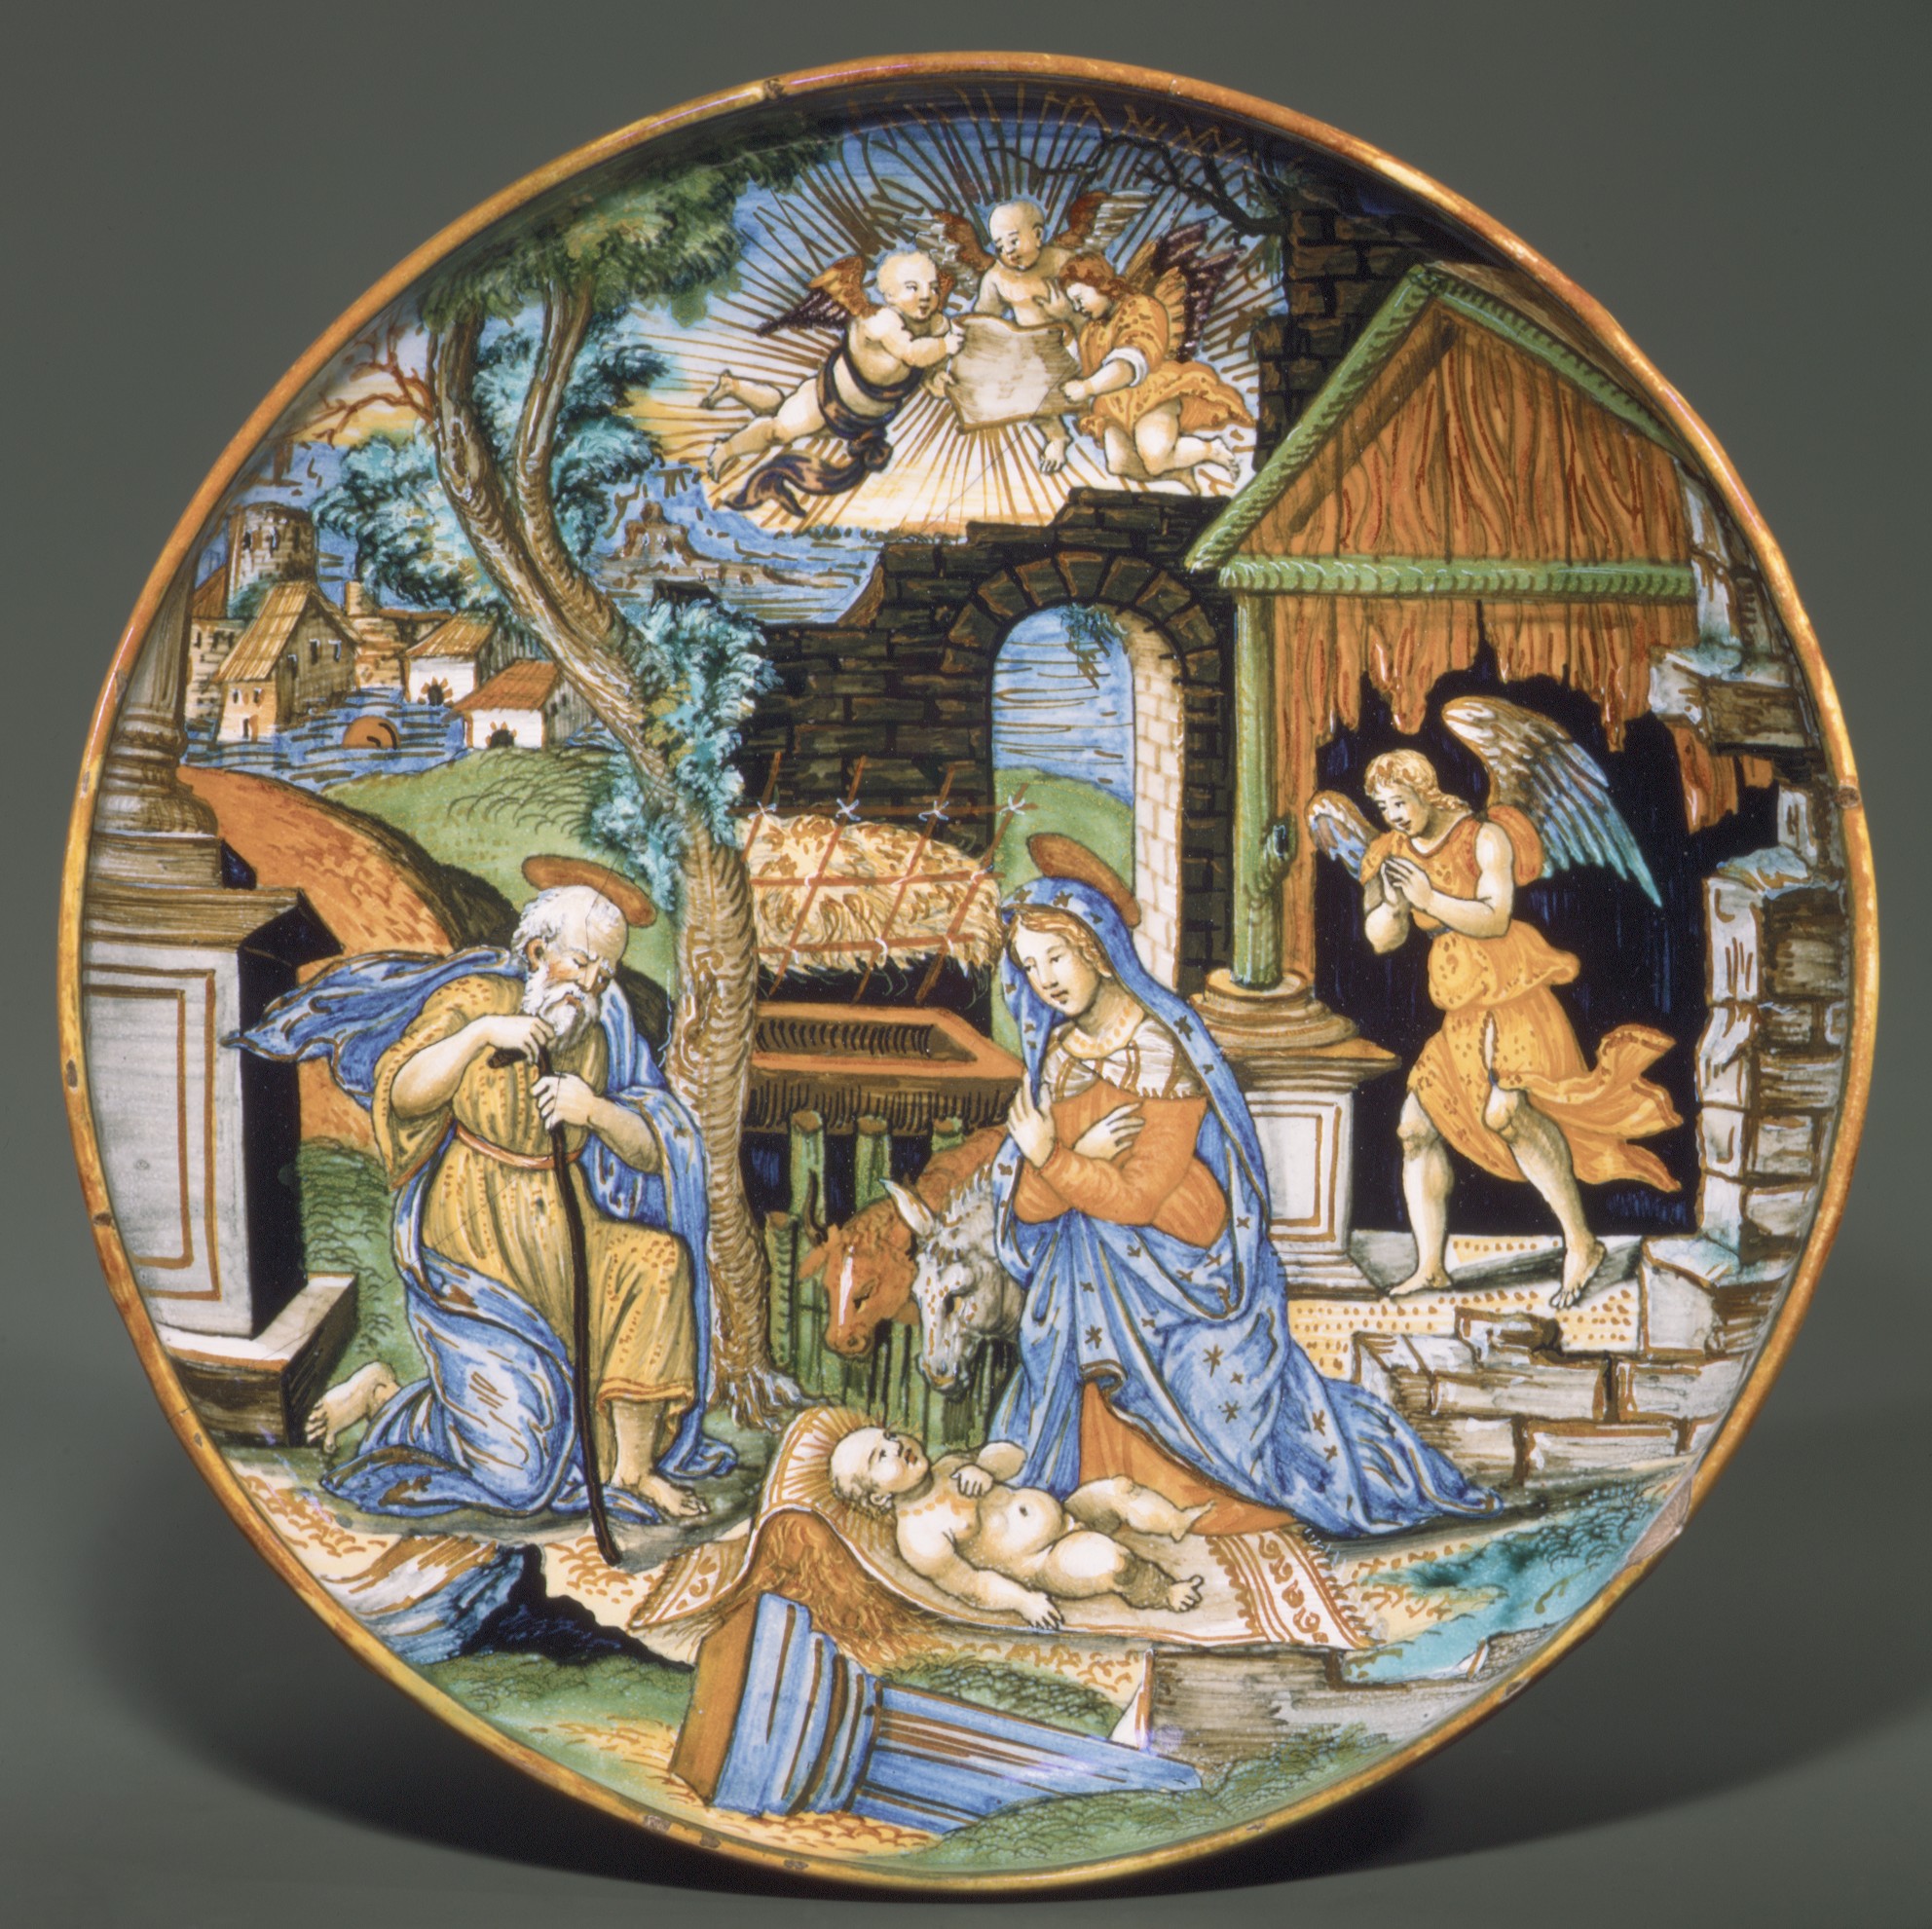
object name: tazza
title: The Nativity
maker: fra xanto avelli da rovigo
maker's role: artist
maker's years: 1486-1582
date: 1538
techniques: maiolica, glazing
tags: angels,madonna and child,nativity